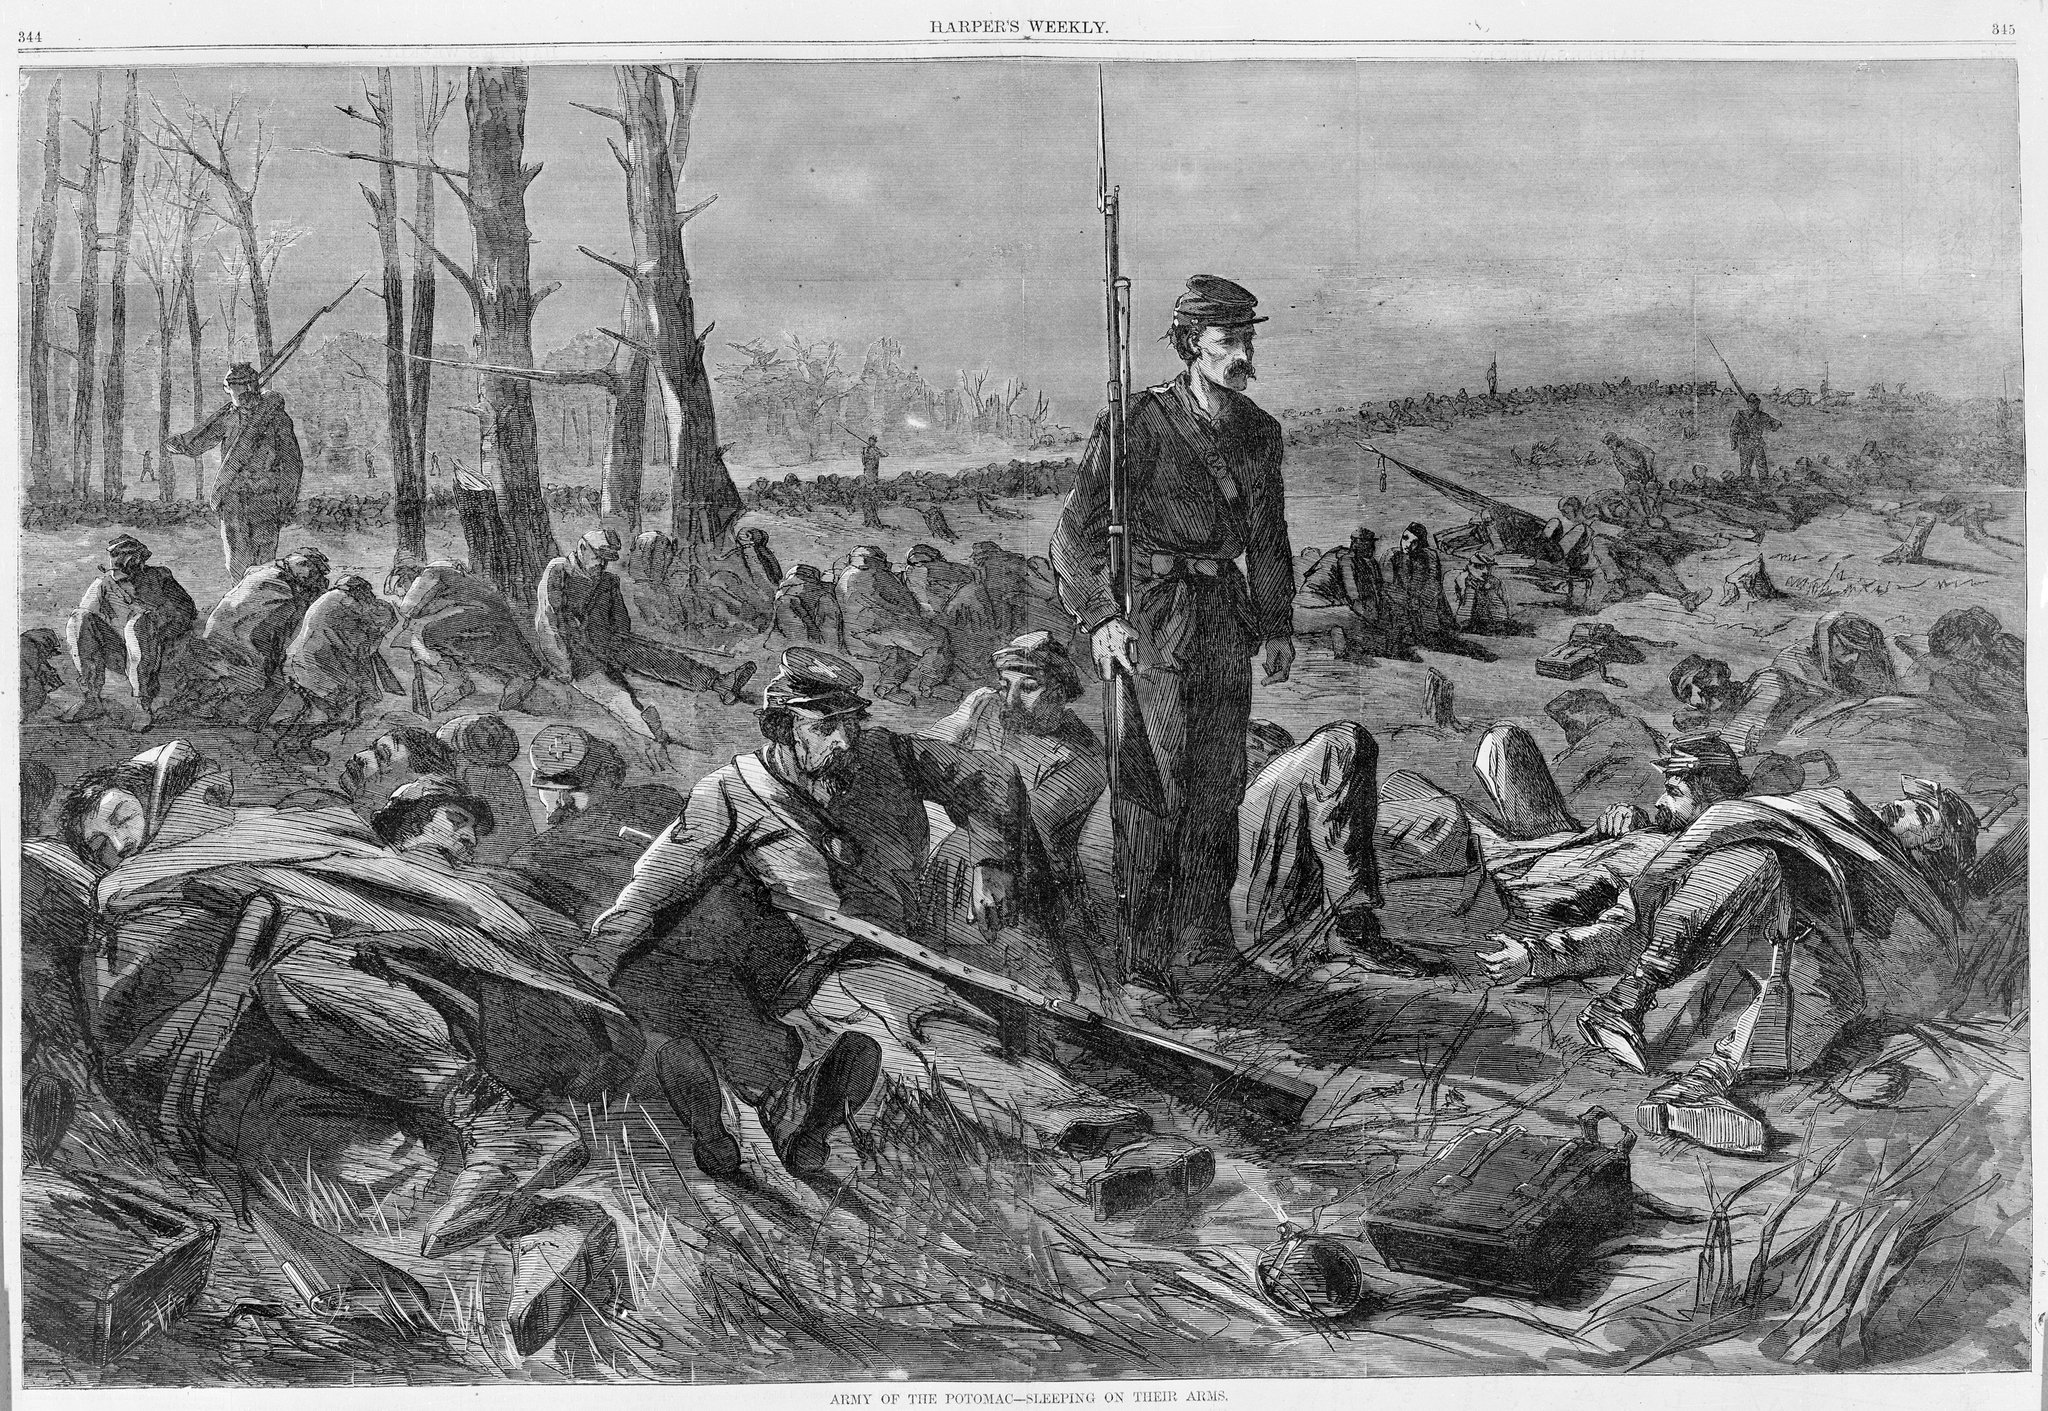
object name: print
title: Army of the Potomac – Sleeping on Their Arms (from "Harper's Weekly," Vol. VIII)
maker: winslow homer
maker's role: artist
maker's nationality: american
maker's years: 1836-1910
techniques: engraving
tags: soldiers,firearms,american civil war,sleeping,men